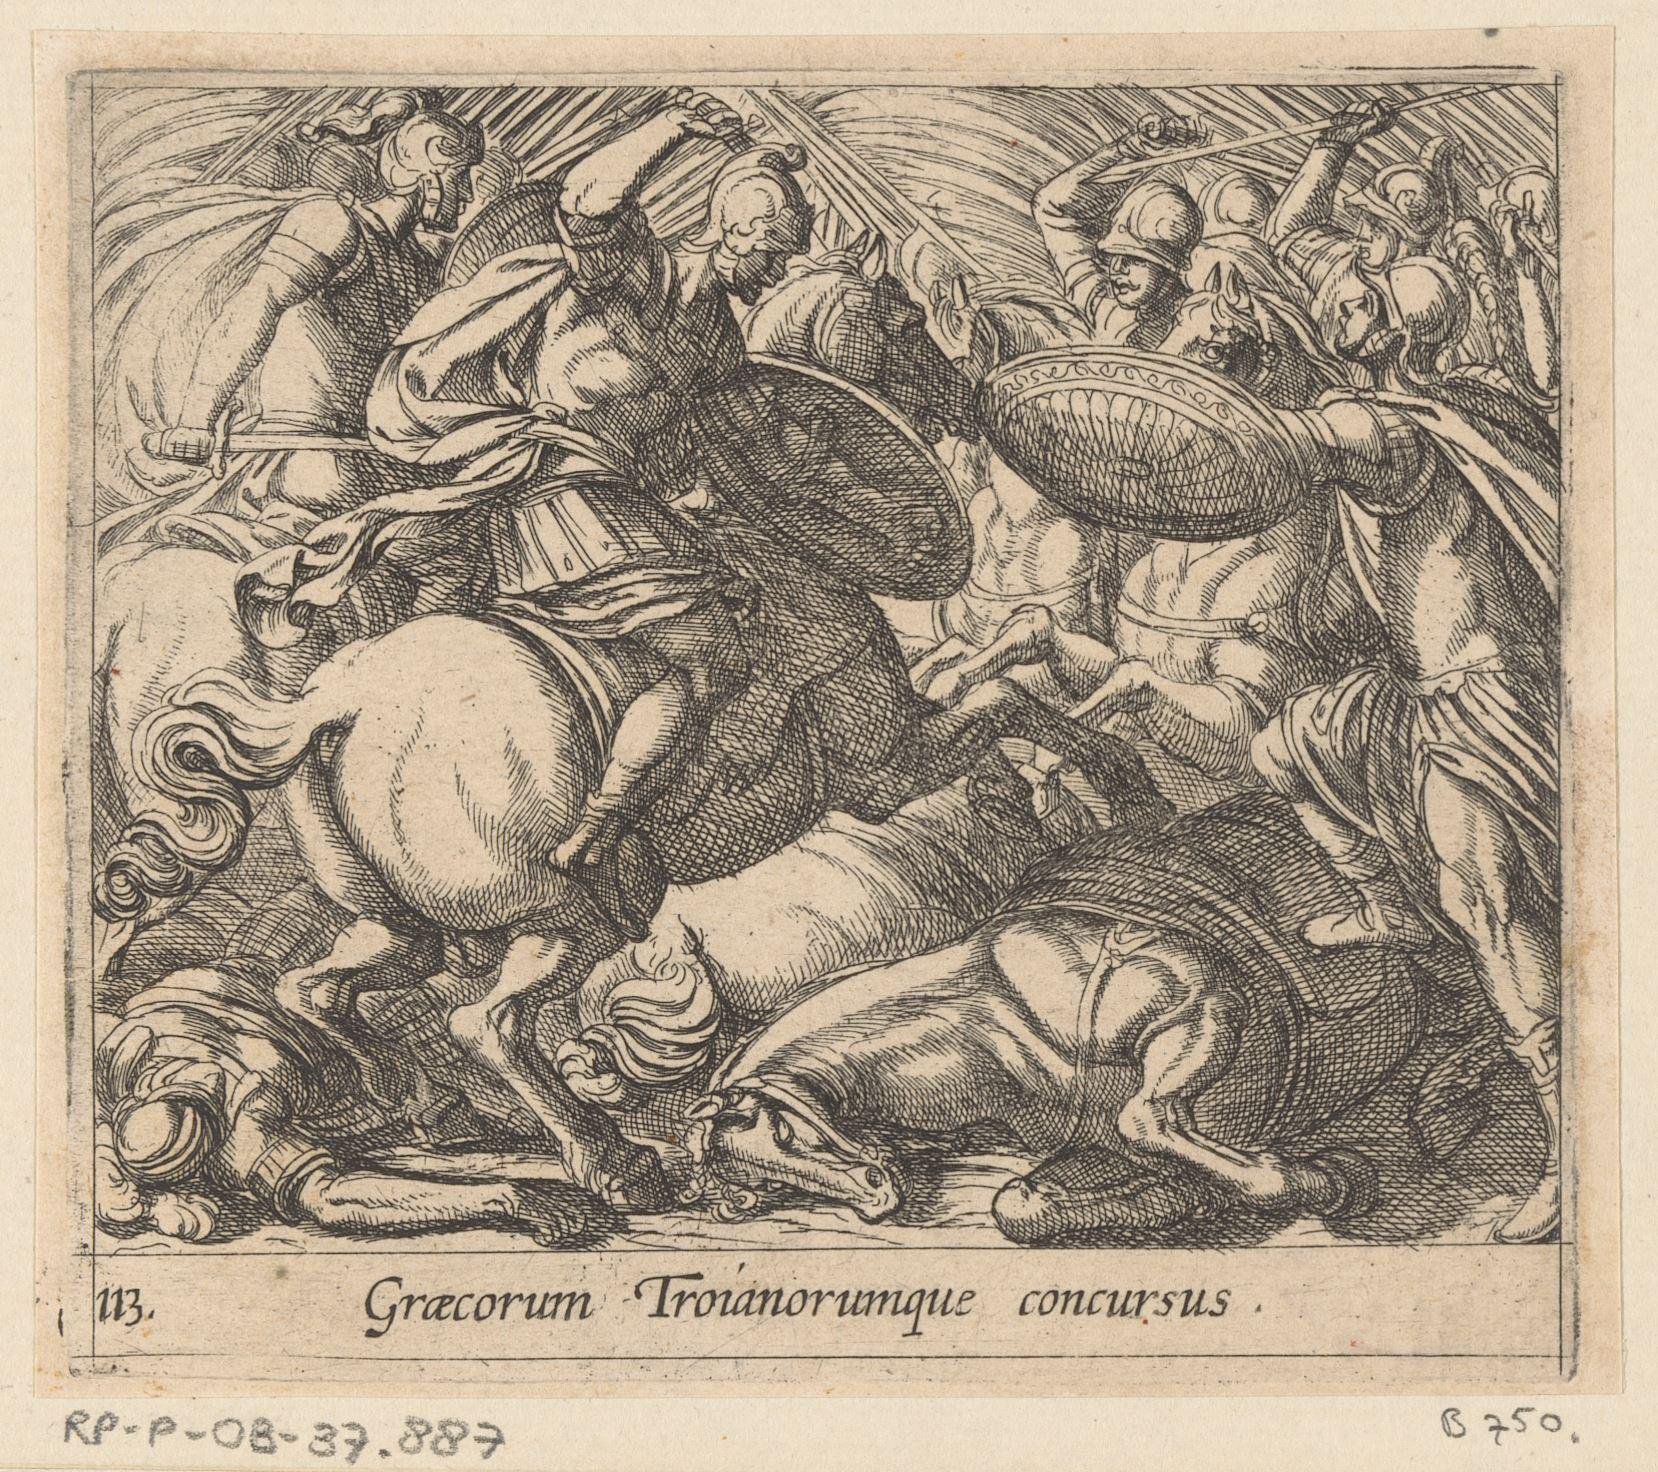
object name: print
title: Graecorum Troianorumque concursus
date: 1606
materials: paper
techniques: etching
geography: antwerp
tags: the trojan war (94c - 94h), battle, warfare; military affairs (+ cavalry, horsemen), the soldier; the soldier's life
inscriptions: collector's mark: Lugt 240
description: Deze prent maakt deel uit van een reeks van 150 prenten (+ titelprent) met voorstellingen van de Metamorfosen van Ovidius.